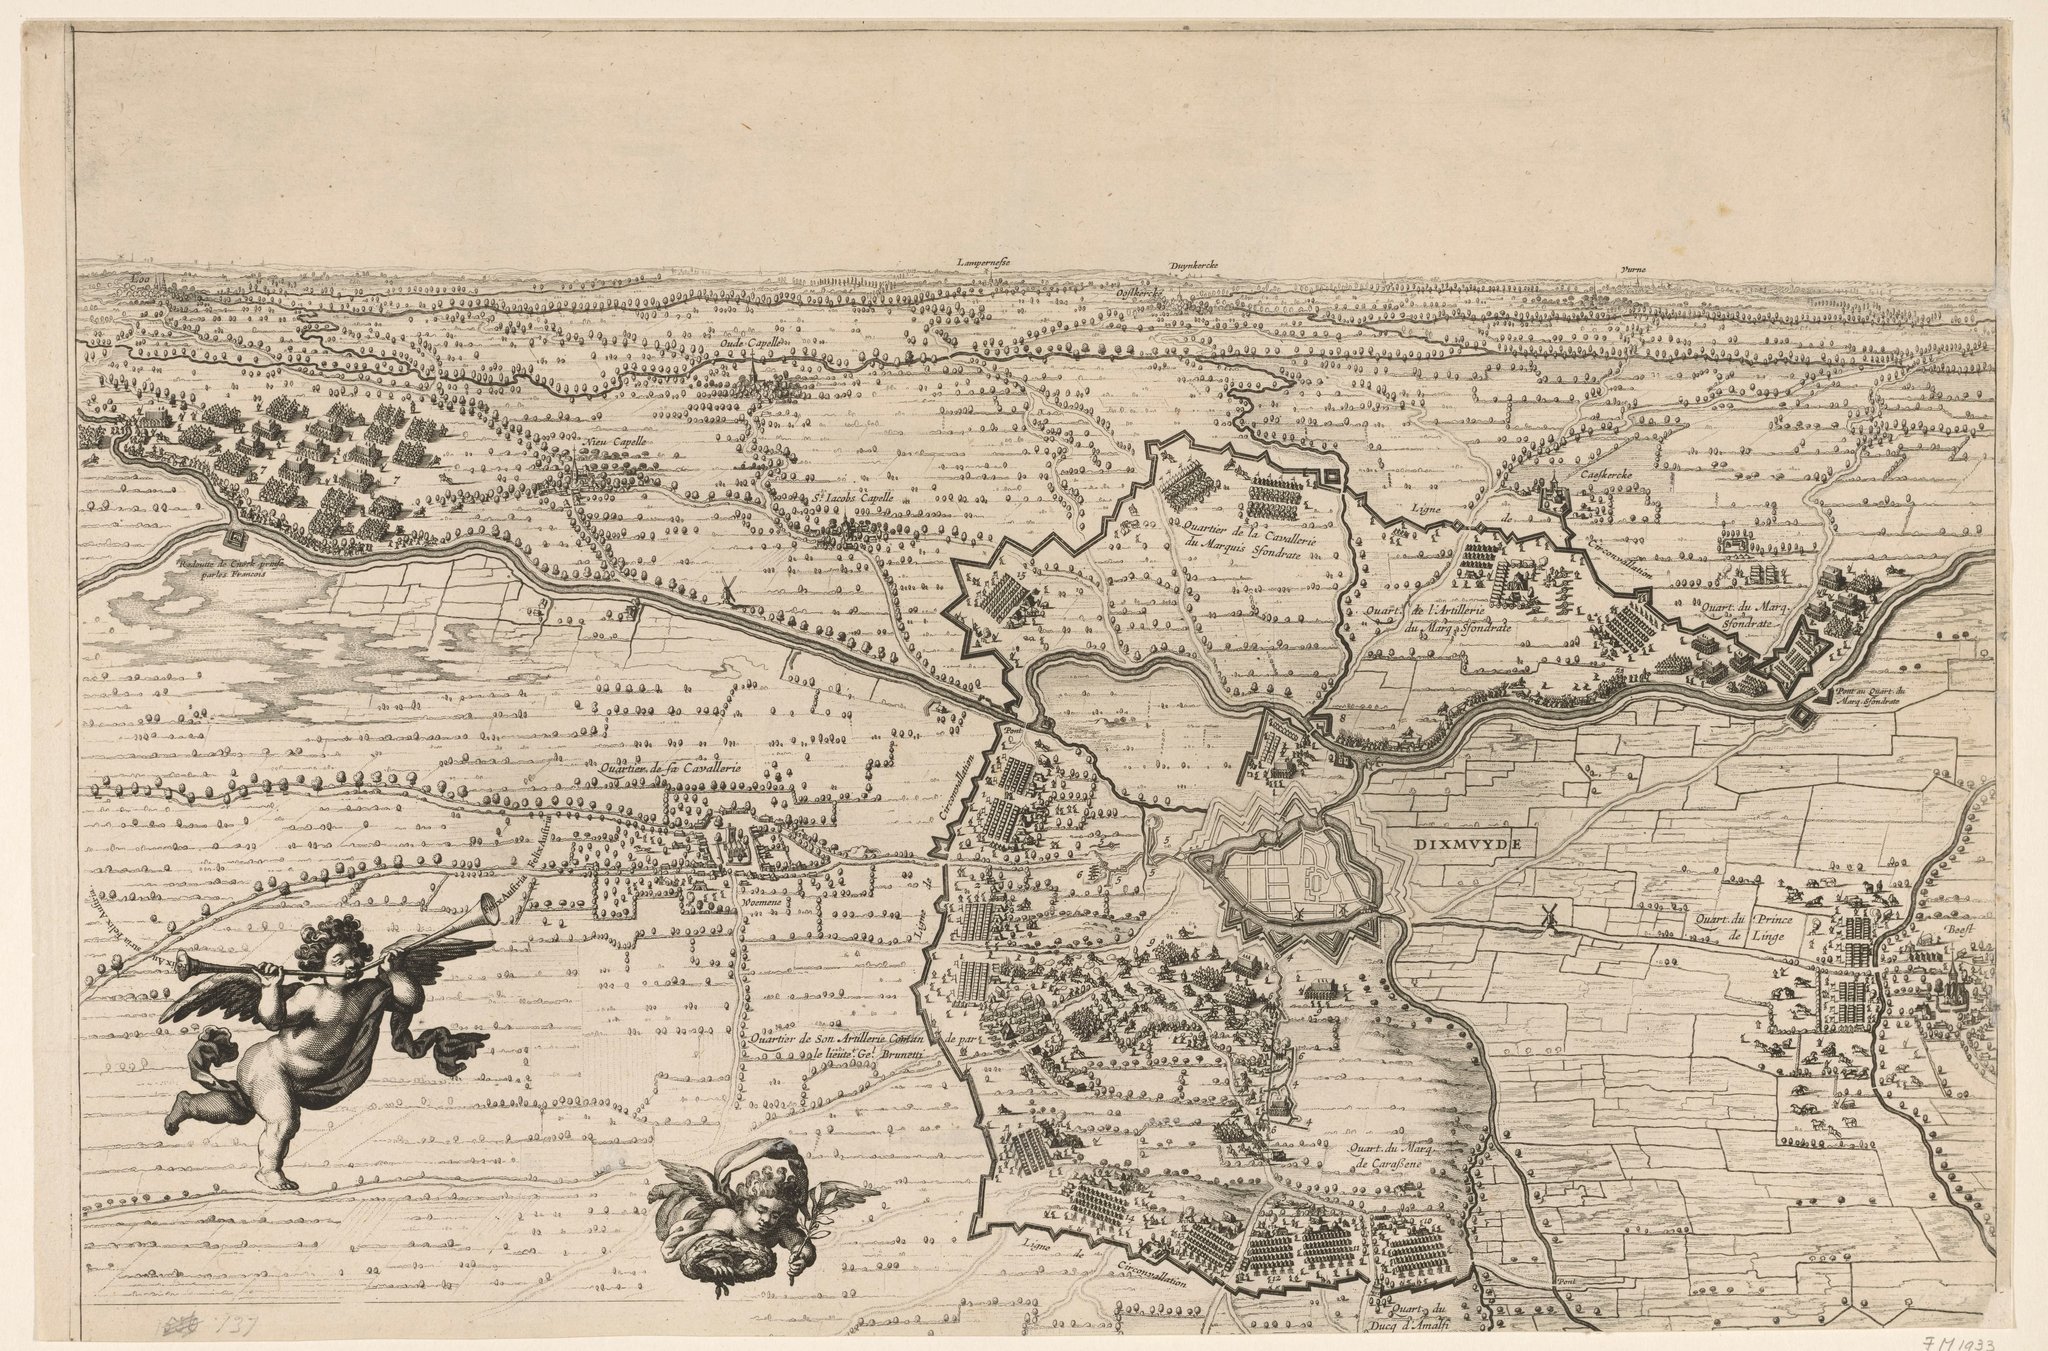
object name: print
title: Kaart van het beleg van Diksmuide, 1647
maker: Anonymous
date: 1647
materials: paper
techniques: etching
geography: southern netherlands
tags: leopold willem van oostenrijk (landvoogd der zuidelijke nederlanden), maps of separate countries or regions, siege, position war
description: Kaart van het beleg van het plaatsje Diksmuide in Vlaanderen op de Fransen door de Spanjaarden onder bevel van landvoogd Leopold Willem. Ongemonteerd geheel bestaande uit drie losse bladen.